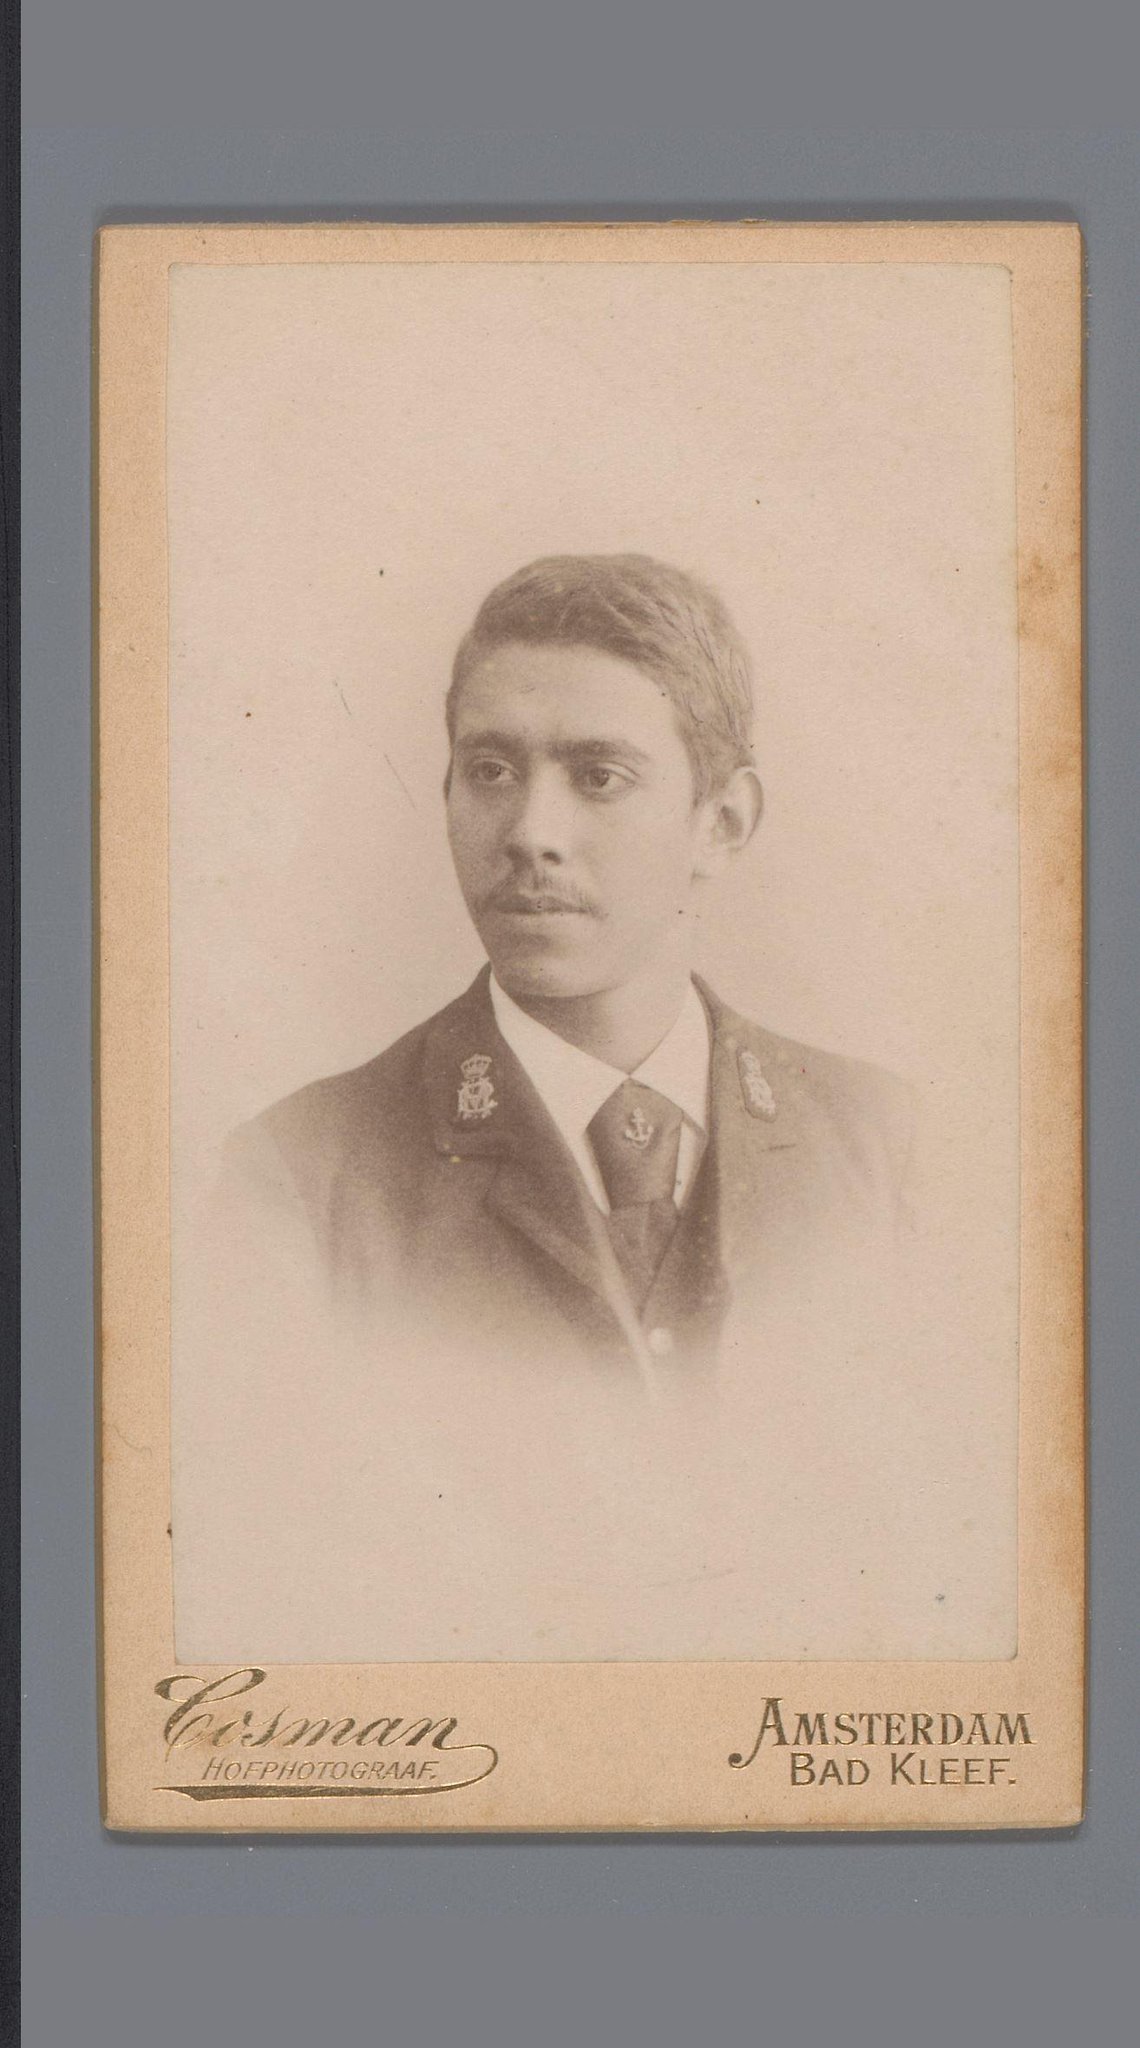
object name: photograph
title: Portret van een onbekende jonge man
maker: max cosman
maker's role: fotograaf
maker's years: 1852-1894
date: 1881-1903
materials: cardboard, paper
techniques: albumen print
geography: amsterdam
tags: youth, adolescent, anonymous historical person portrayed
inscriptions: address: ‘Amsterdam/ Koningsplein 1/ (hoek Singel.)/ Galerij 48./ Filiaal Bad Kleef./ Koningsplein No 1,/ Gebouw Kosmos Verzekeringsbank.’, inscription: ‘Specialiteit/ in/ Vergrootingen. Kooldruk Onveranderlijk./ De plaat blijft voor nabestelling bewaard.’